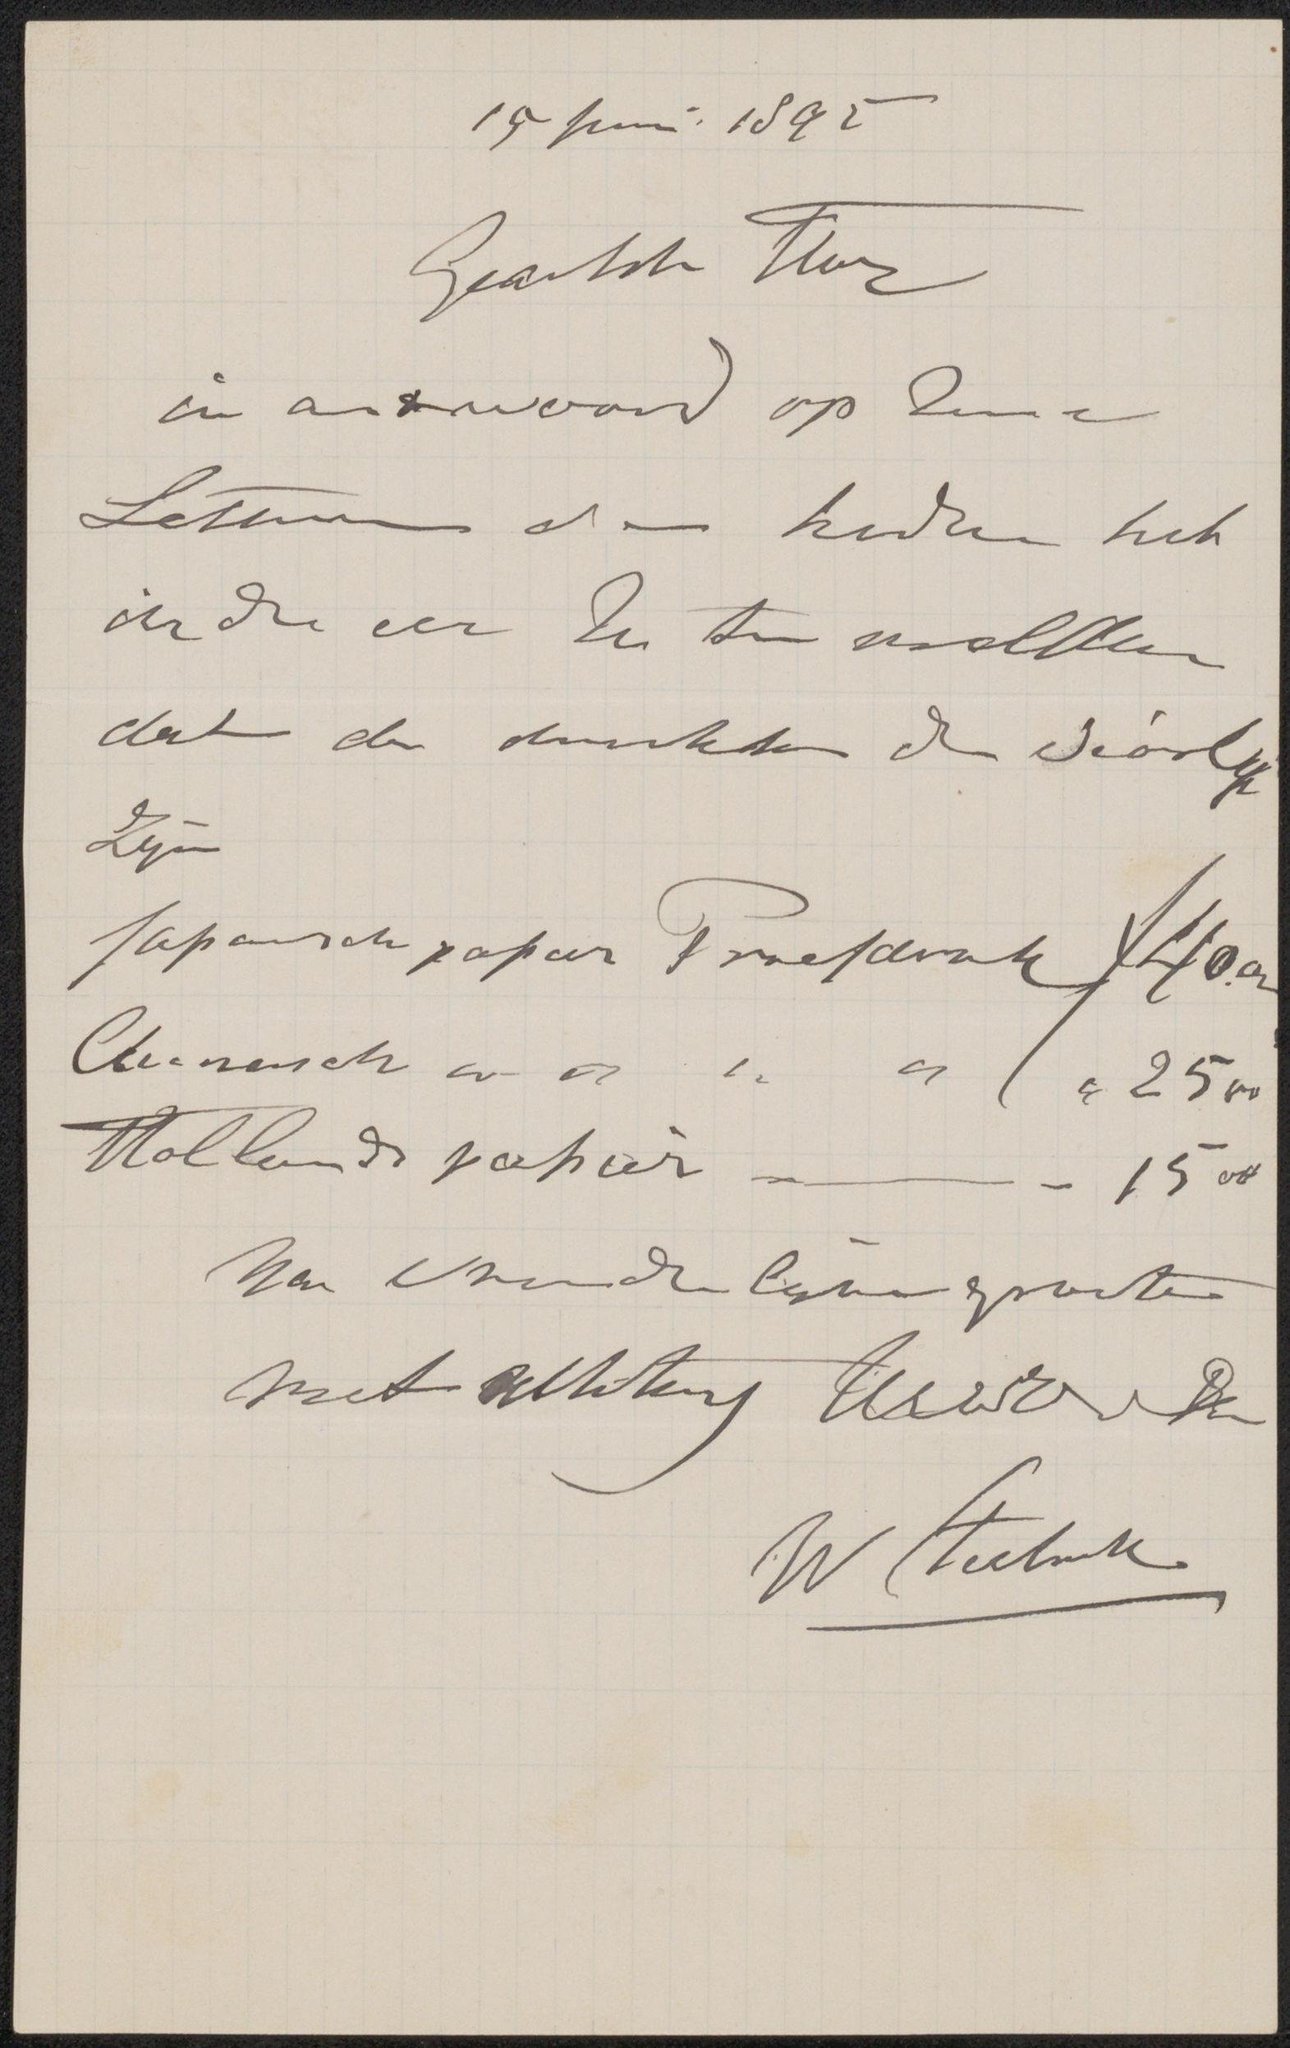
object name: letter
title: Brief aan anoniem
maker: willem steelink (i)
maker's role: draughtsman, print maker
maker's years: 1826-1913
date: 1895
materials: ink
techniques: pen, writing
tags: the graphic arts, money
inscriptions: watermark